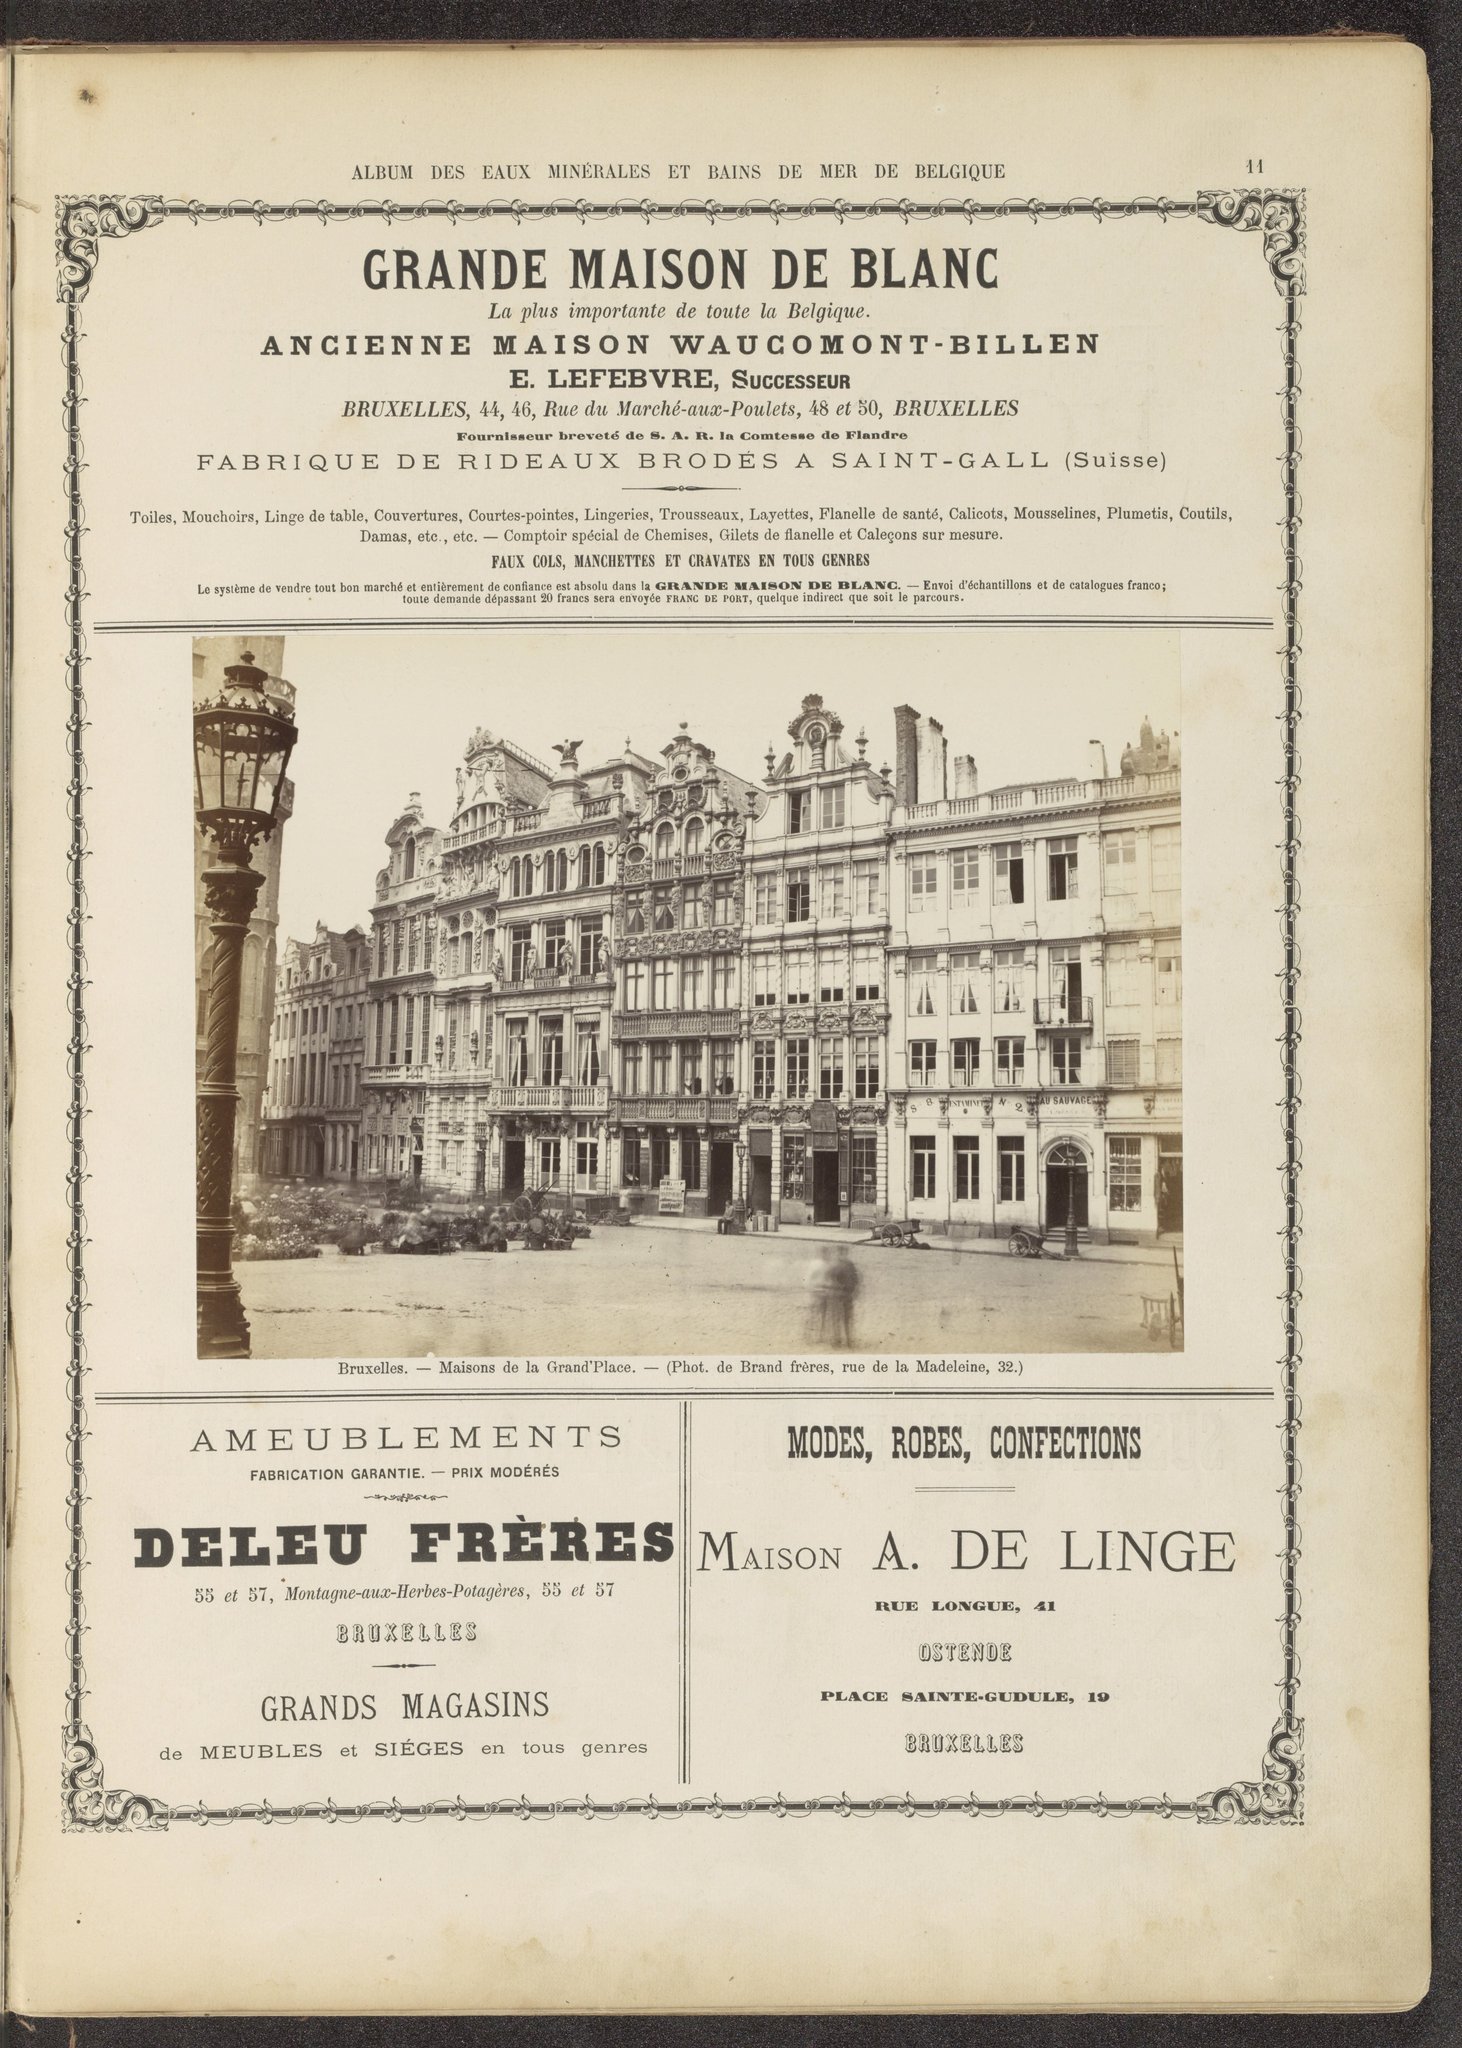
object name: page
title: Bruxelles - Maisons de la Grand'Place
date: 1862-1872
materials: photographic support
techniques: albumen print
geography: grote markt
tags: square, place, circus, etc., façade (of house or building)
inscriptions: name: ‘(Phot. de Brand frères, rue de la Madeleine, 32.)’